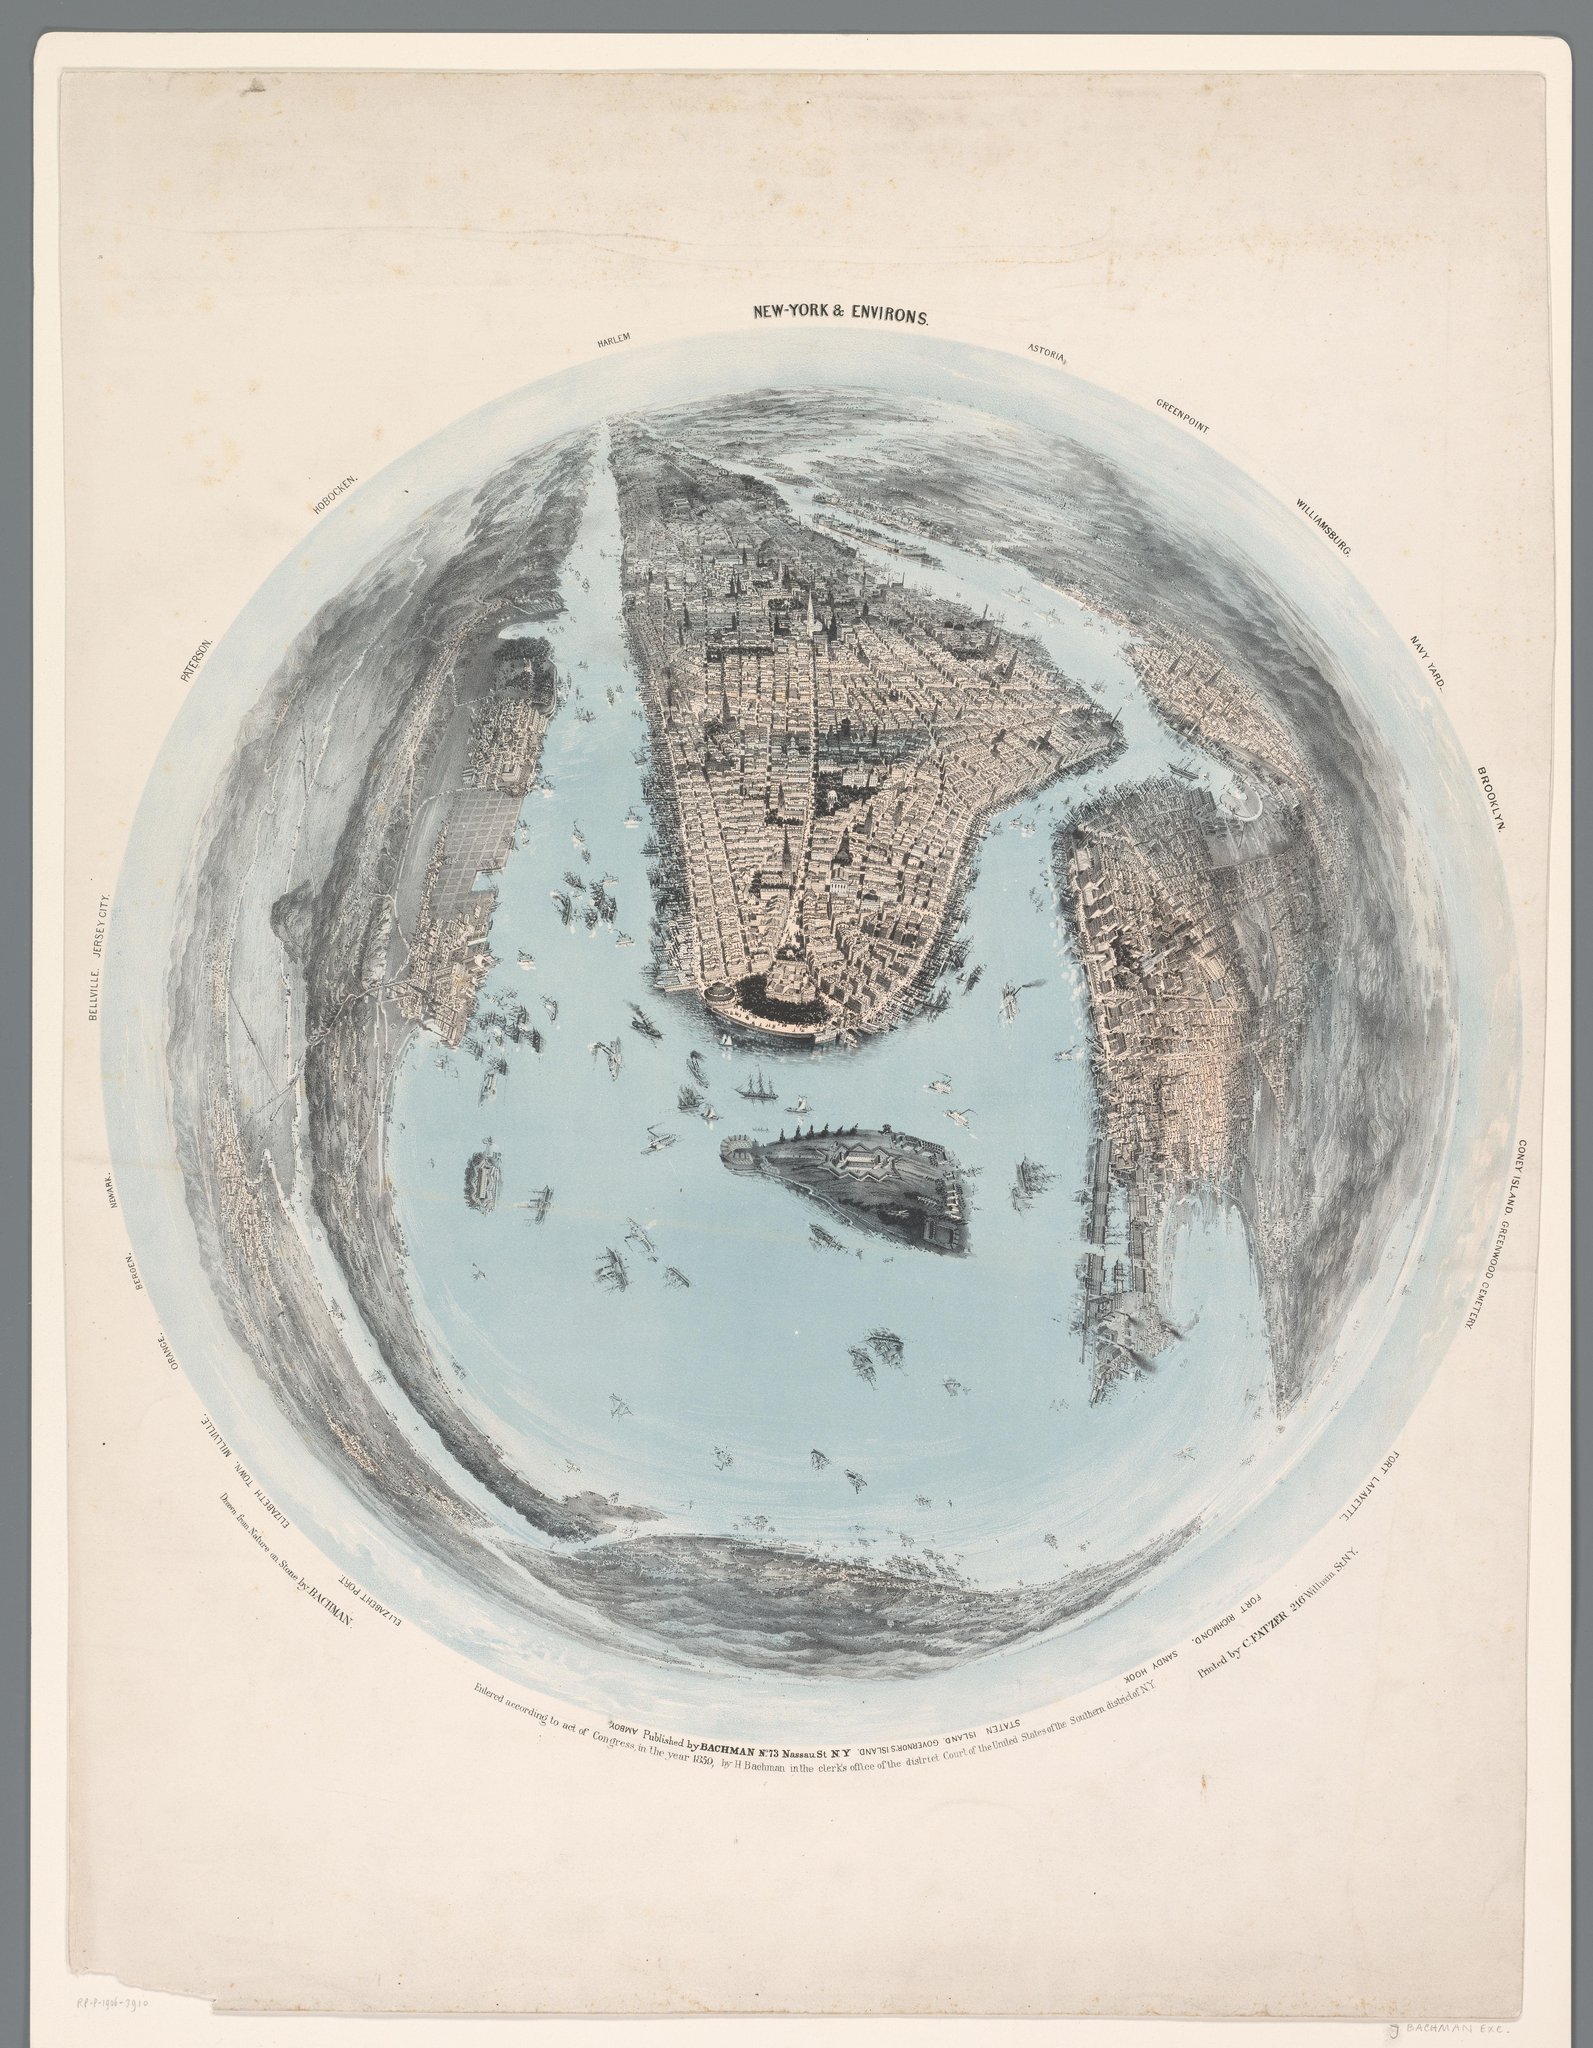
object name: print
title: New-York & environs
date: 1859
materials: paper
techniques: tone lithography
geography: united states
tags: harbour, maps of cities, traffic on the water, new york (city)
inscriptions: collector's mark: Lugt 2228